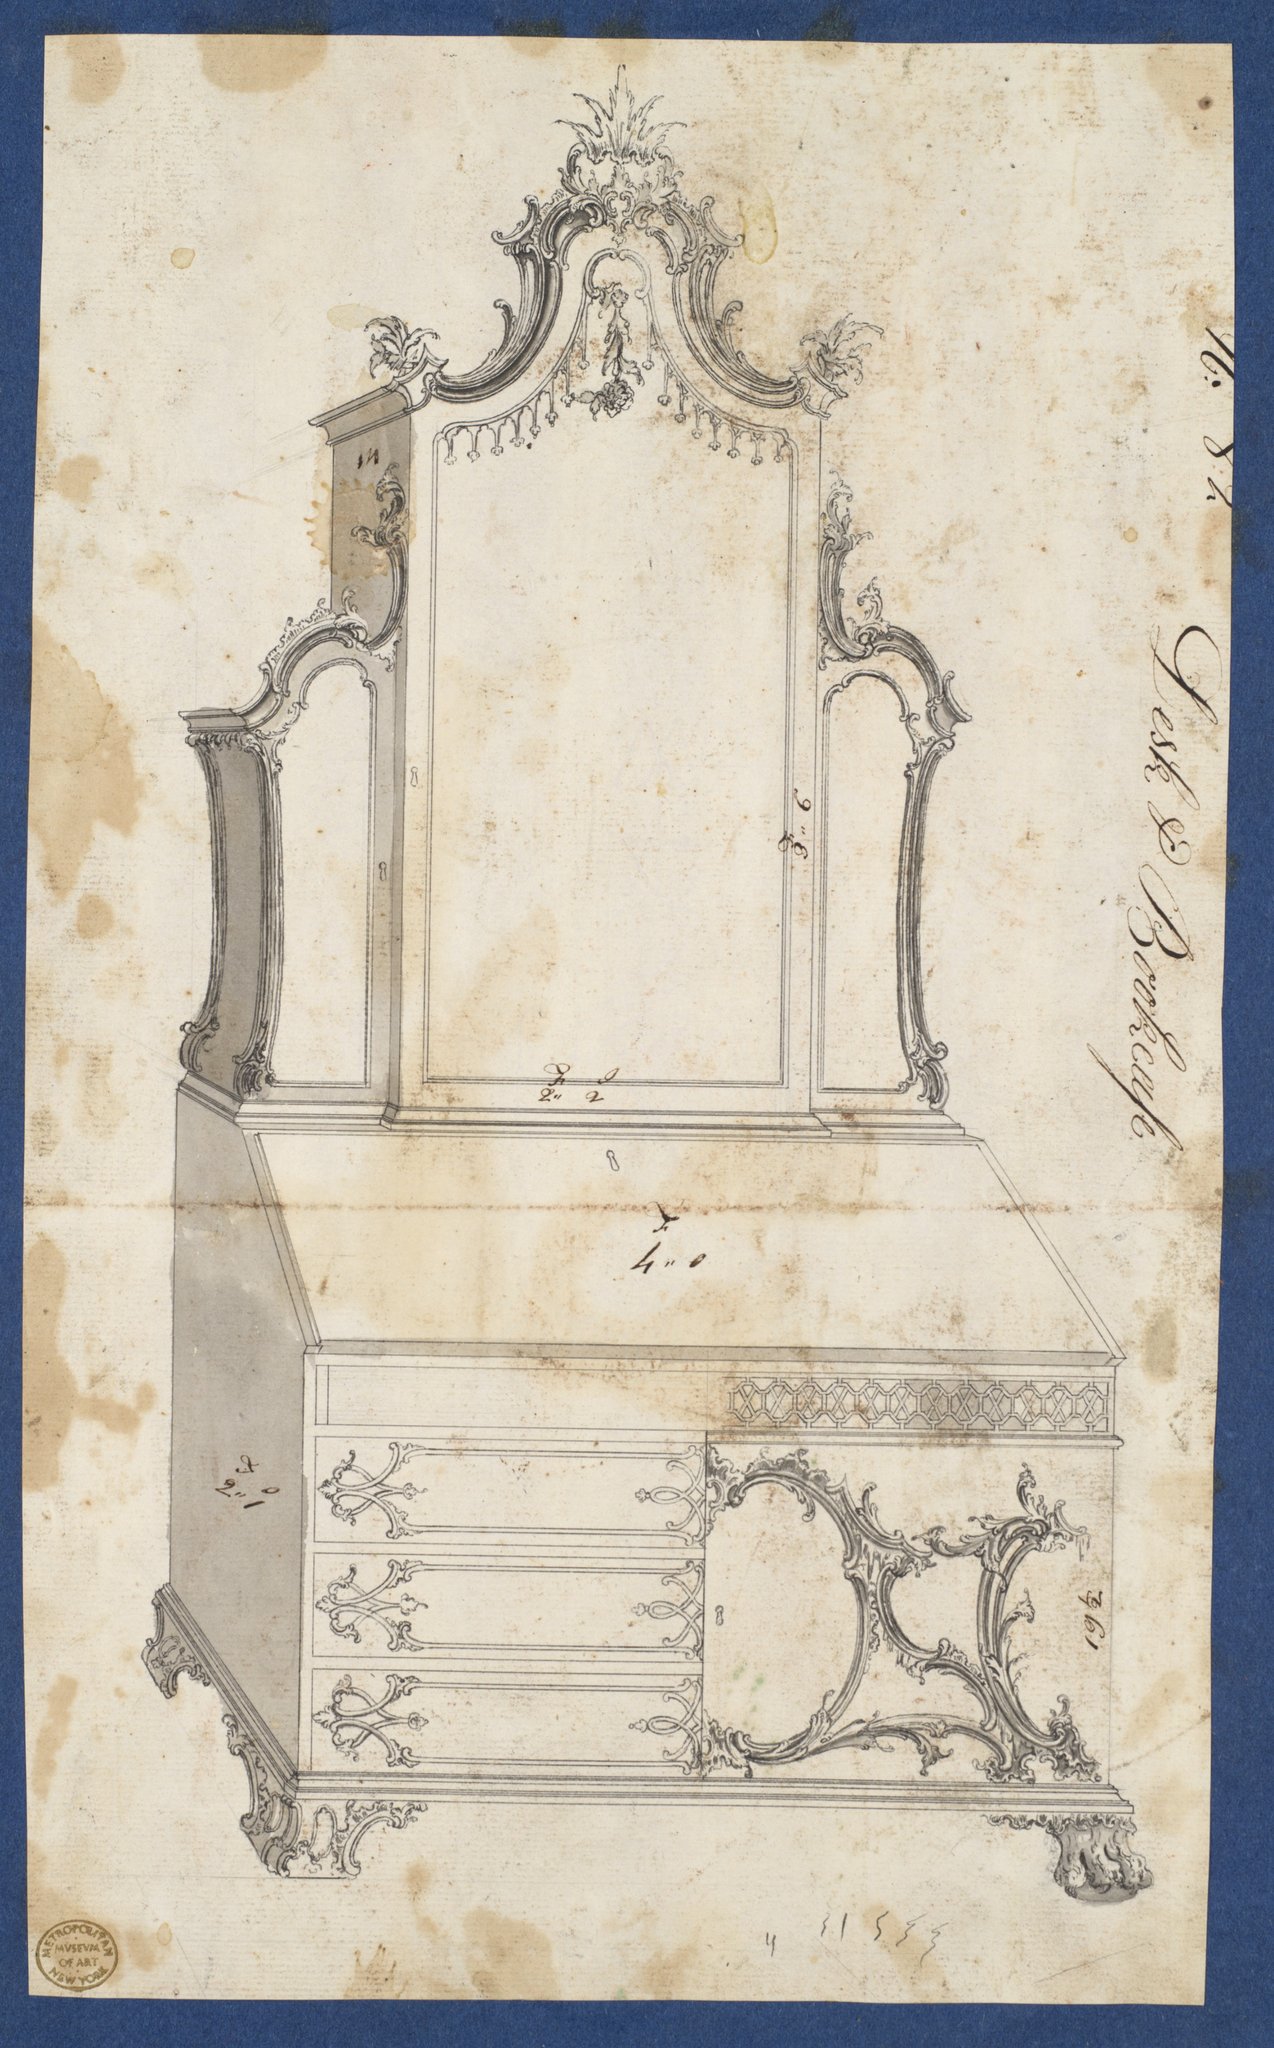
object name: drawing ornament architecture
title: Desk and Bookcase, from Chippendale Drawings, Vol. II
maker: thomas chippendale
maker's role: artist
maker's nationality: british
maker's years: 1718-1779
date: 1753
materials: ink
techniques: wash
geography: london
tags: desks,cabinets